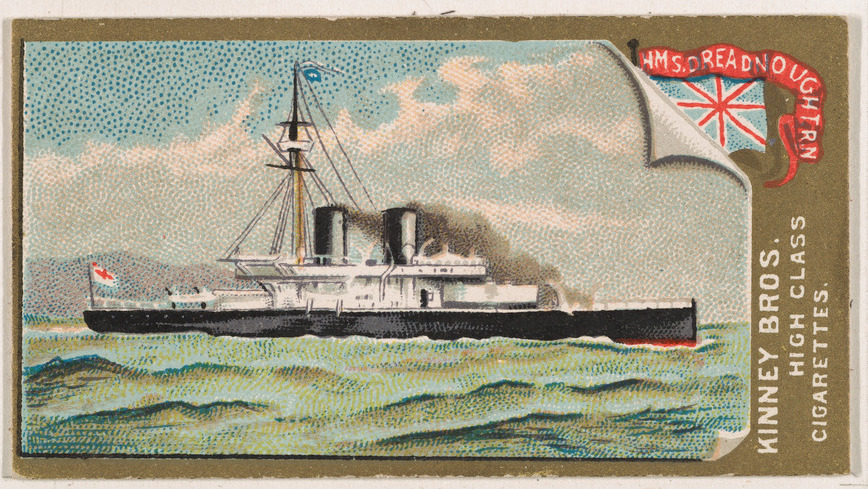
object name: print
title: H.M.S. Dreadnought, Royal Navy, from the Naval Vessels of the World series (N226) issued by Kinney Bros.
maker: kinney brothers tobacco company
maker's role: publisher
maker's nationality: american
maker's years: 1869-2011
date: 1889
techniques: color lithograph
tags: navy,ships